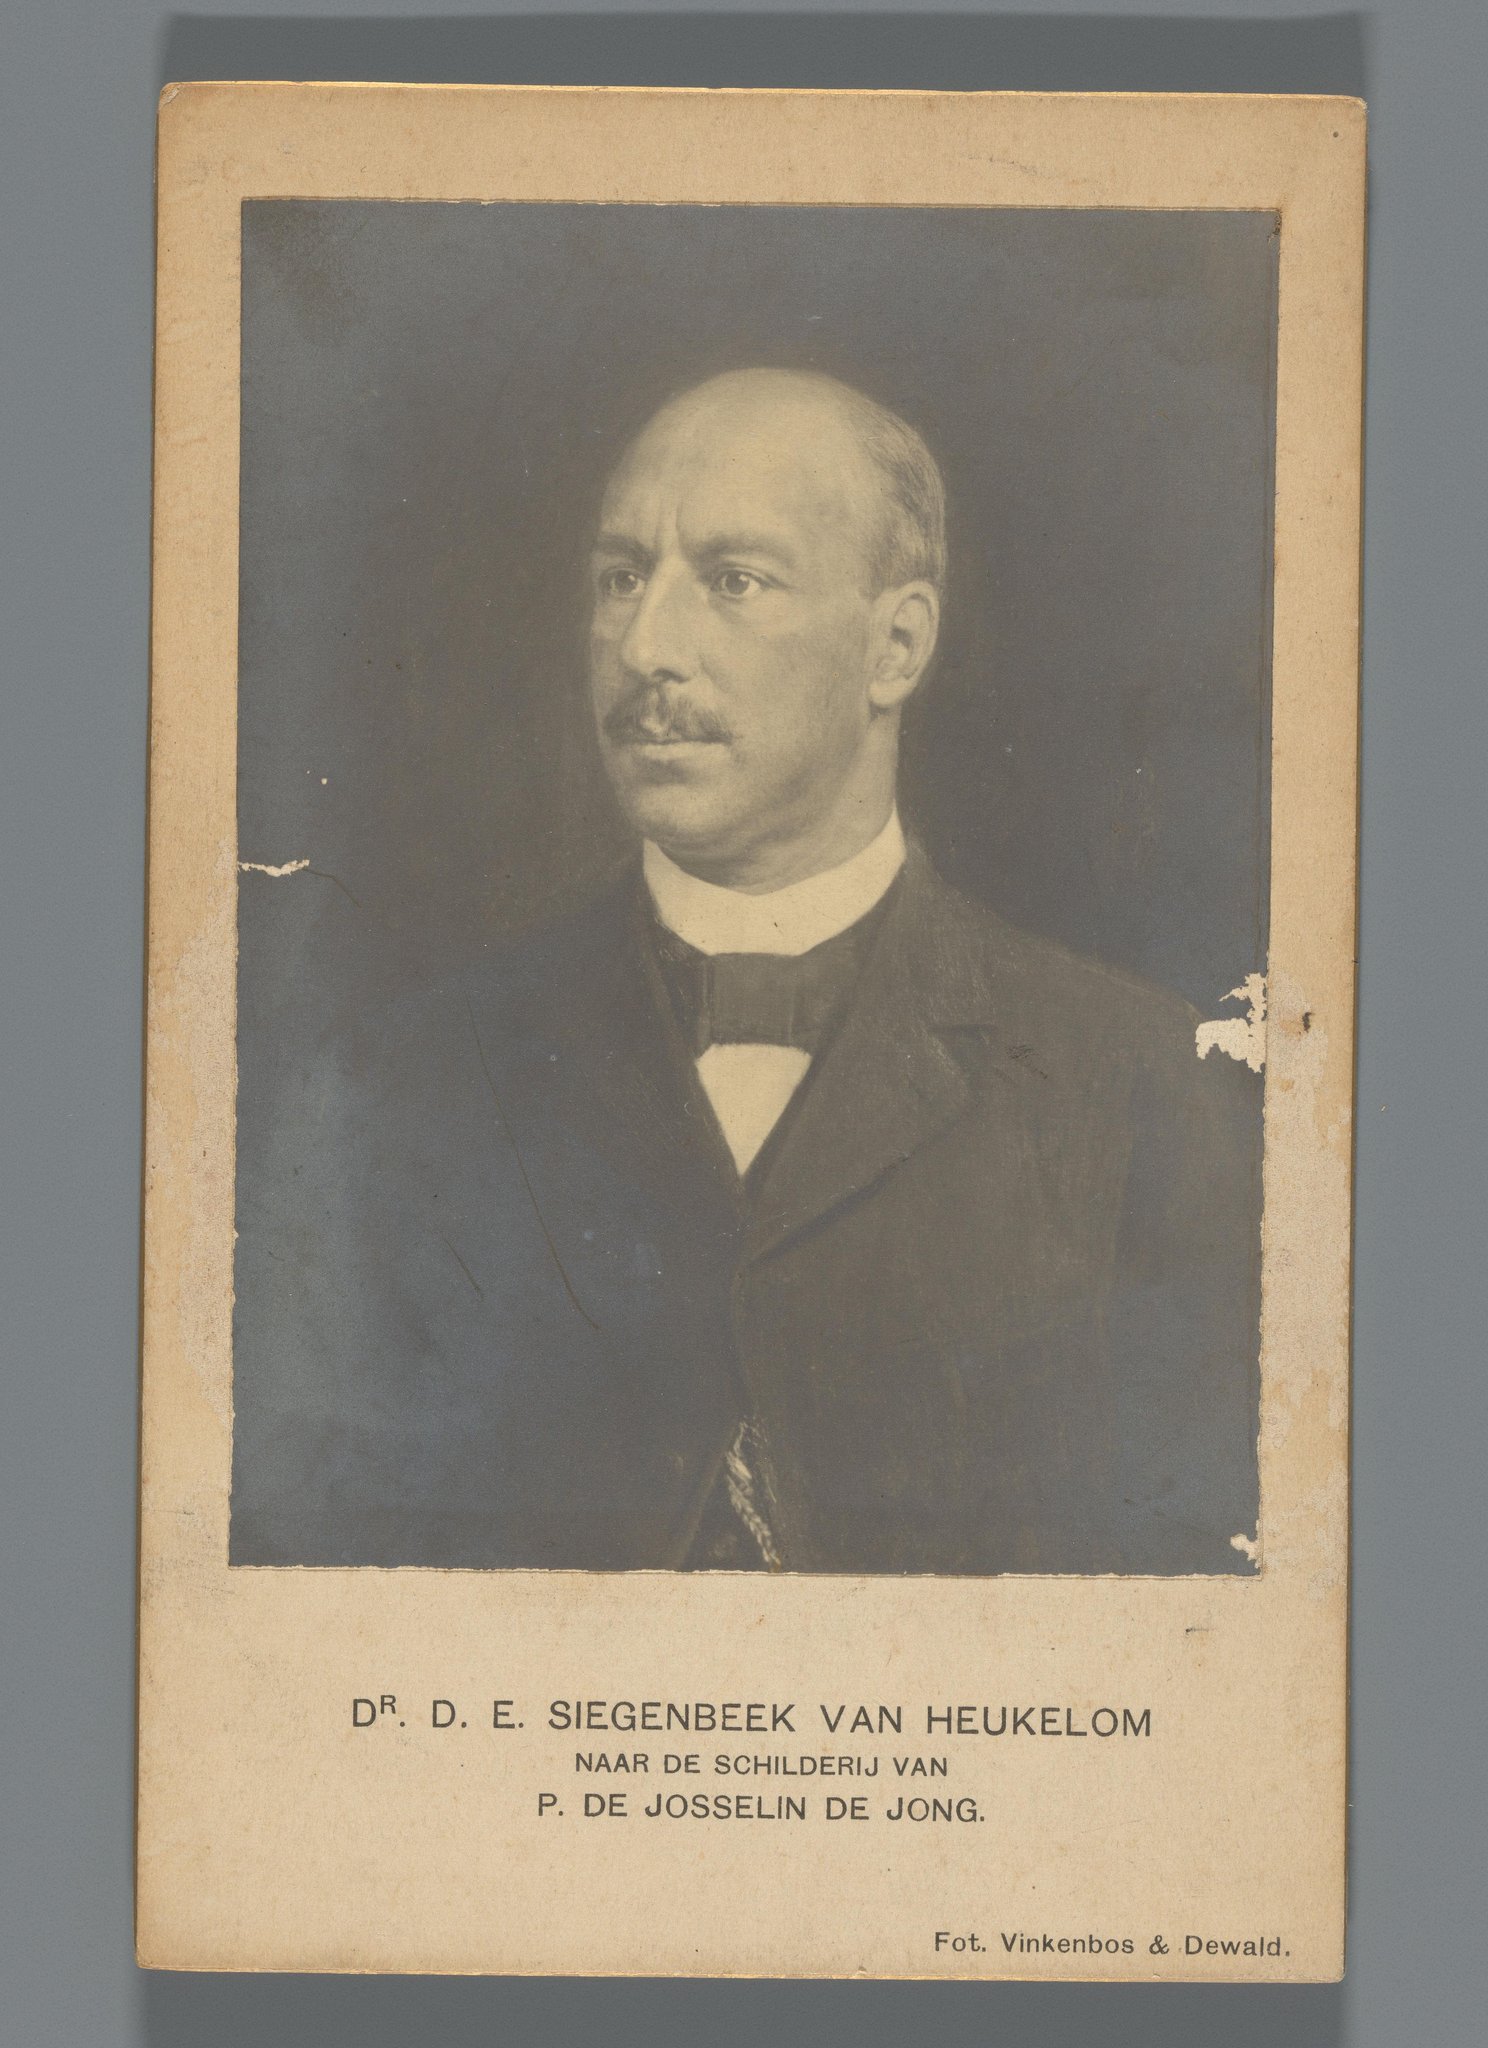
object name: reproduction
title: Fotoreproductie van een geschilderd portret van Daniel Eliza Siegenbeek van Heukelom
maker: pieter de josselin de jong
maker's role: draughtsman, painter, print maker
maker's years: 1861-1906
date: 1890-1920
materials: paper, cardboard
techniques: gelatin silver print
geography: the hague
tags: leiden, historical persons